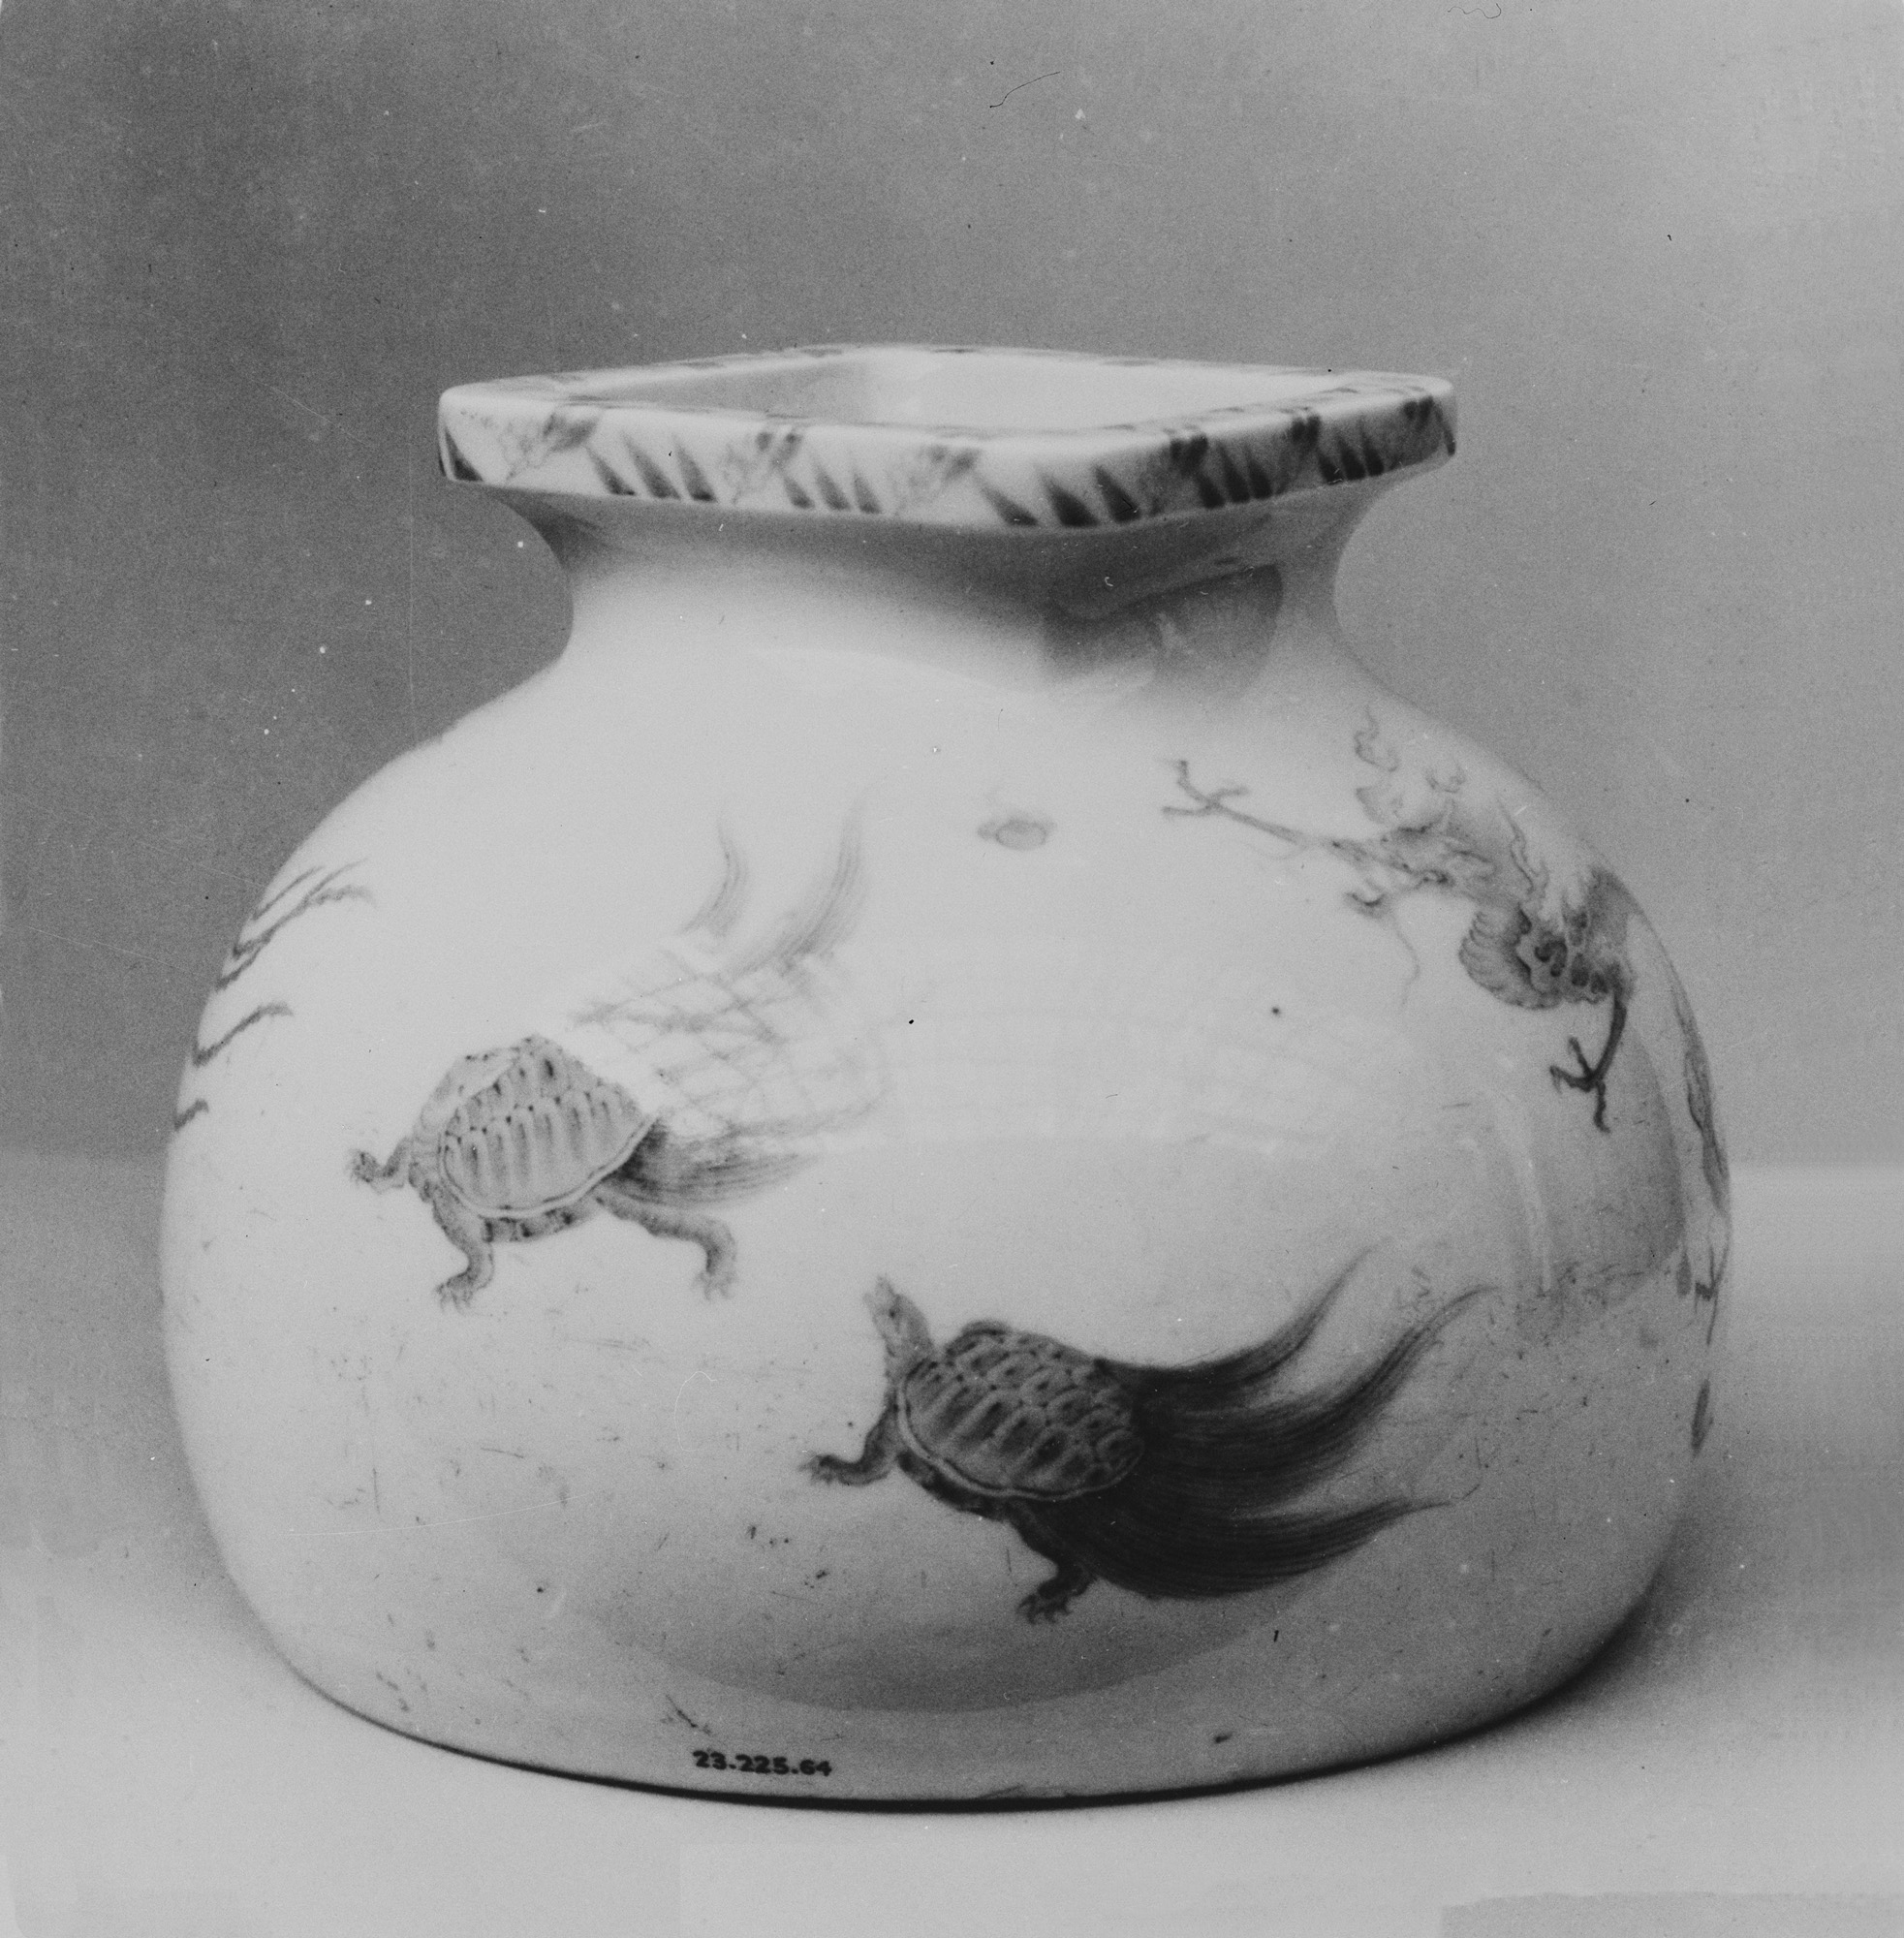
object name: vase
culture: japanese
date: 1760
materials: glaze, porcelain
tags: mythical creatures